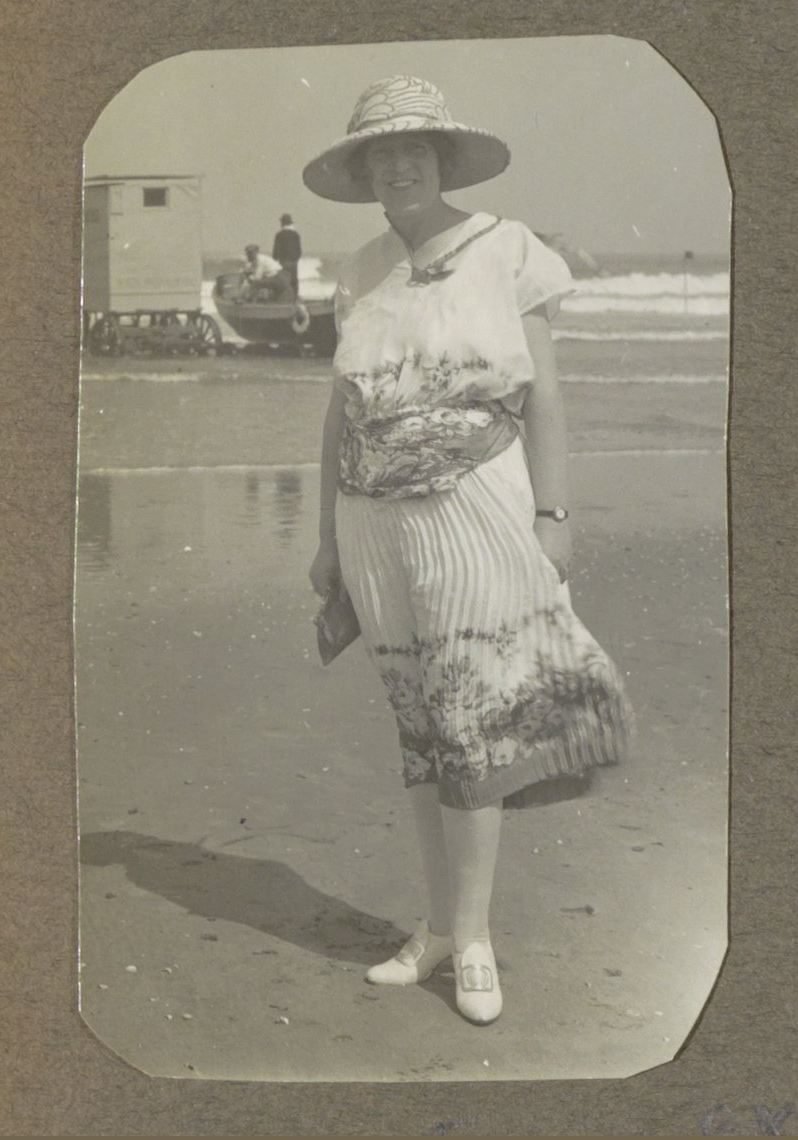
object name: photograph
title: Vrouw met hoed op het strand, vermoedelijk in Nederland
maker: Anonymous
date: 1920-1930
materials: photographic support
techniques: gelatin silver print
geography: netherlands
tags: beach (as place of recreation), adult woman, netherlands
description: Onderdeel van fotoalbum van een onbekende Nederlandse familie met opnames van Suriname, Europa en Nederlands-Indië.